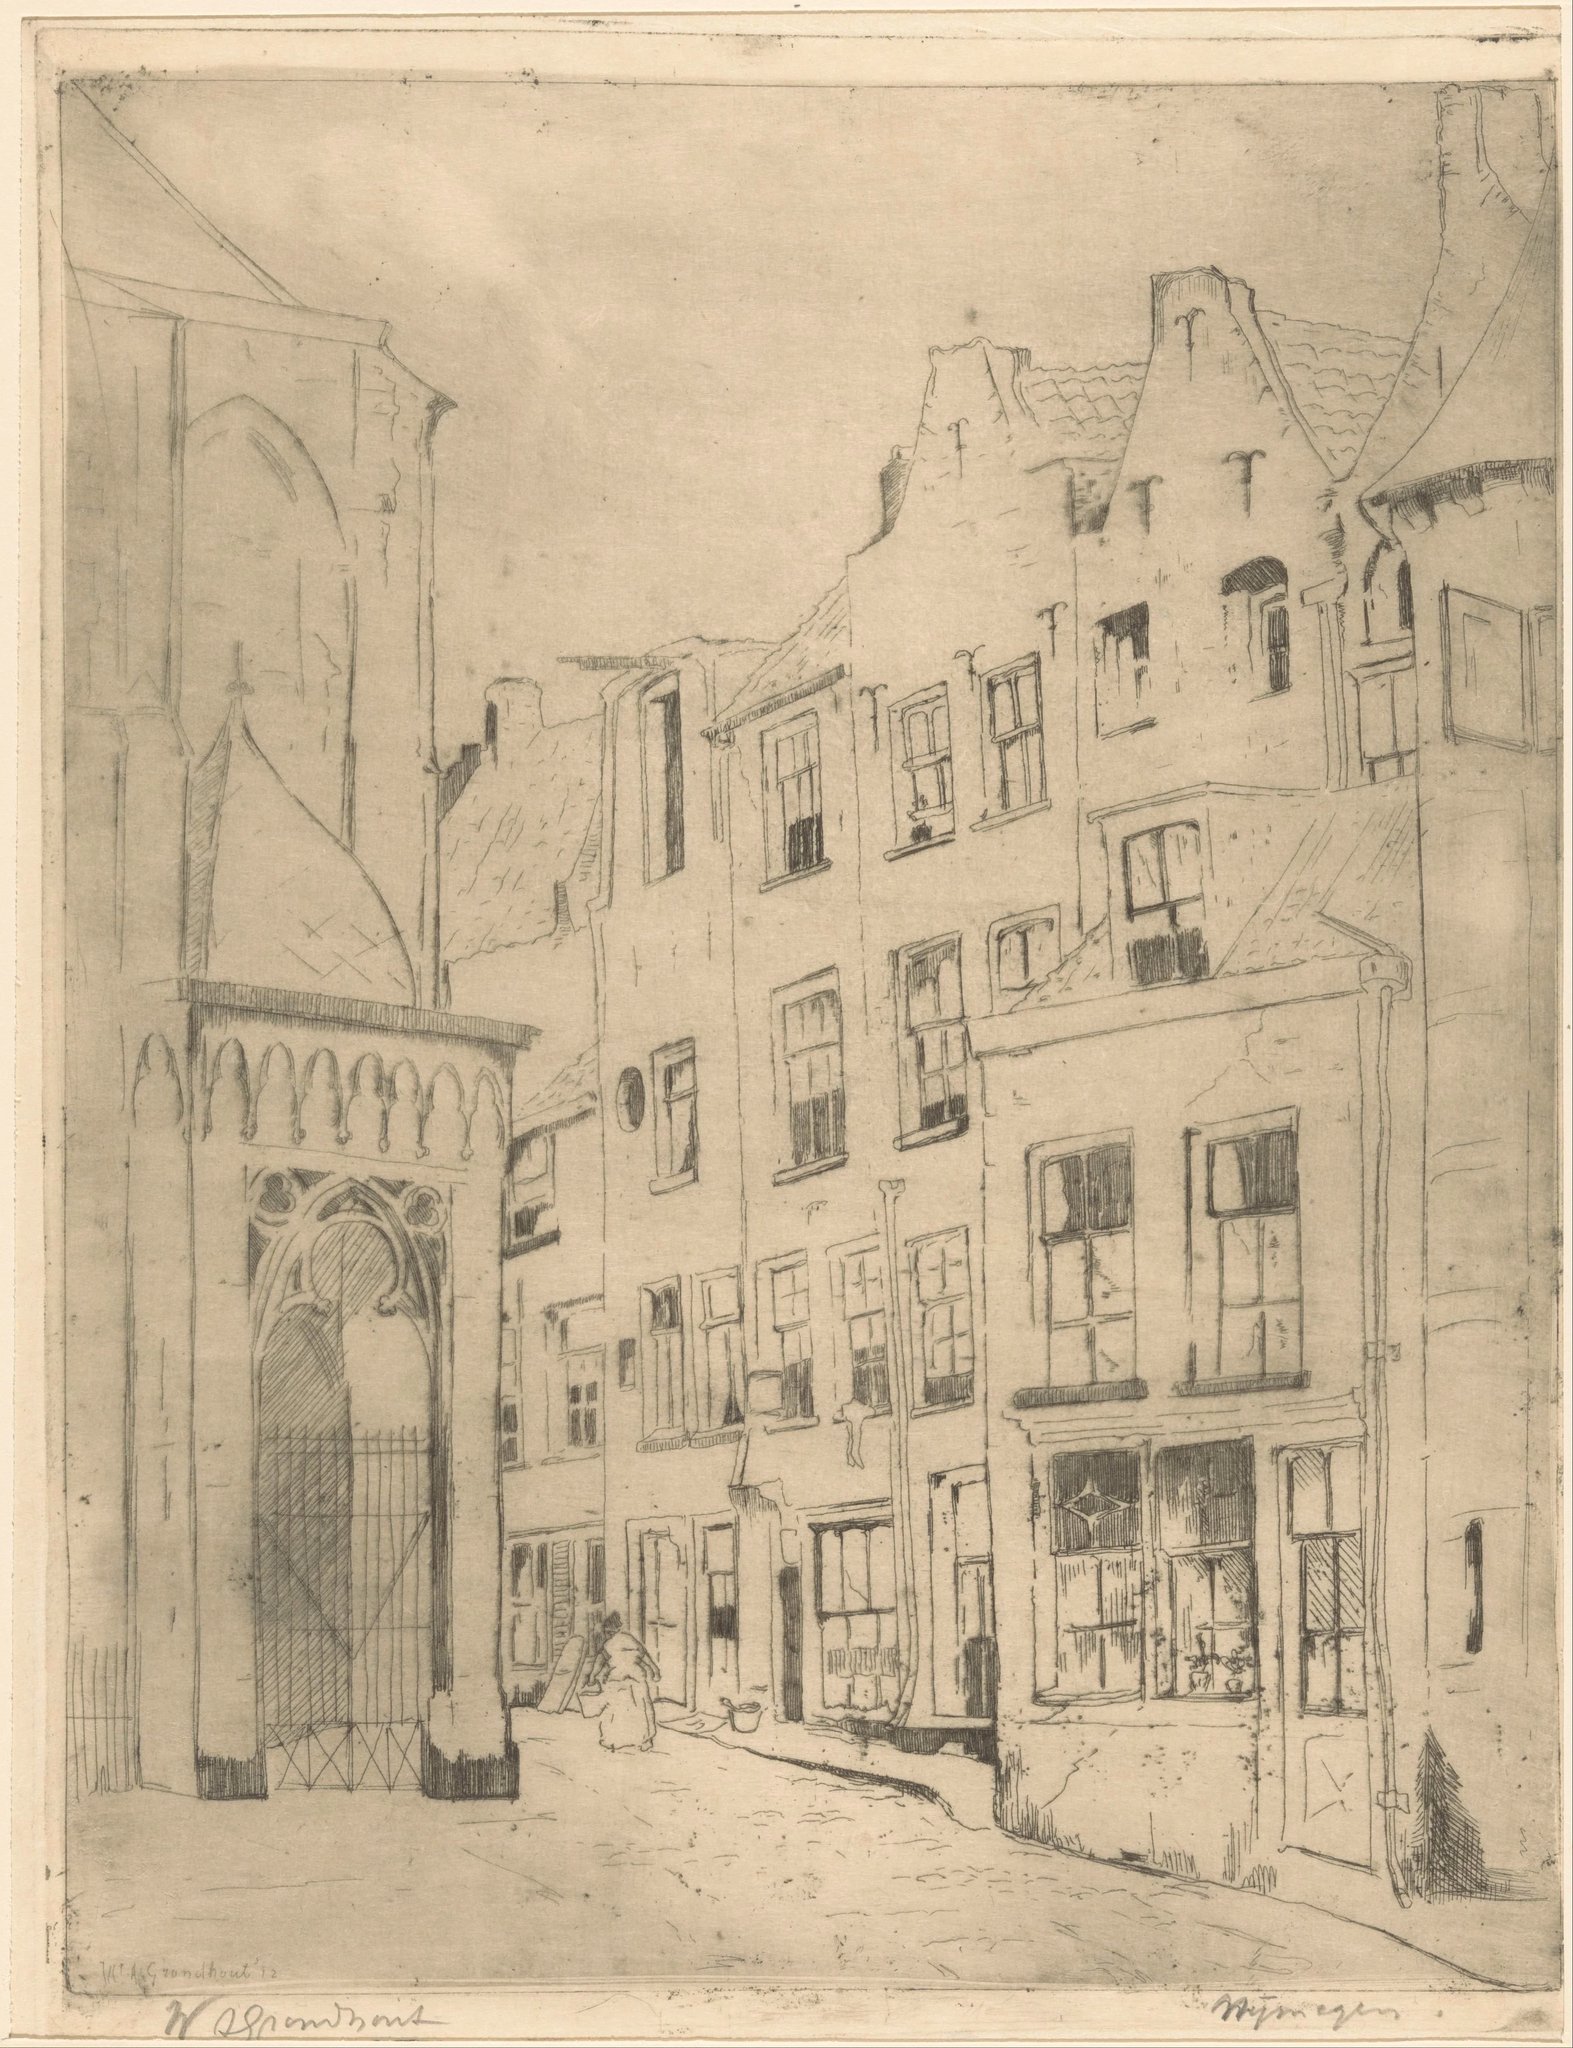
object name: print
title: Nijmegen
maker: willem adrianus grondhout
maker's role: draughtsman, painter, print maker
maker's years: 1878-1934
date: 1912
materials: paper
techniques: etching, intaglio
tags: church (exterior), street, nijmegen